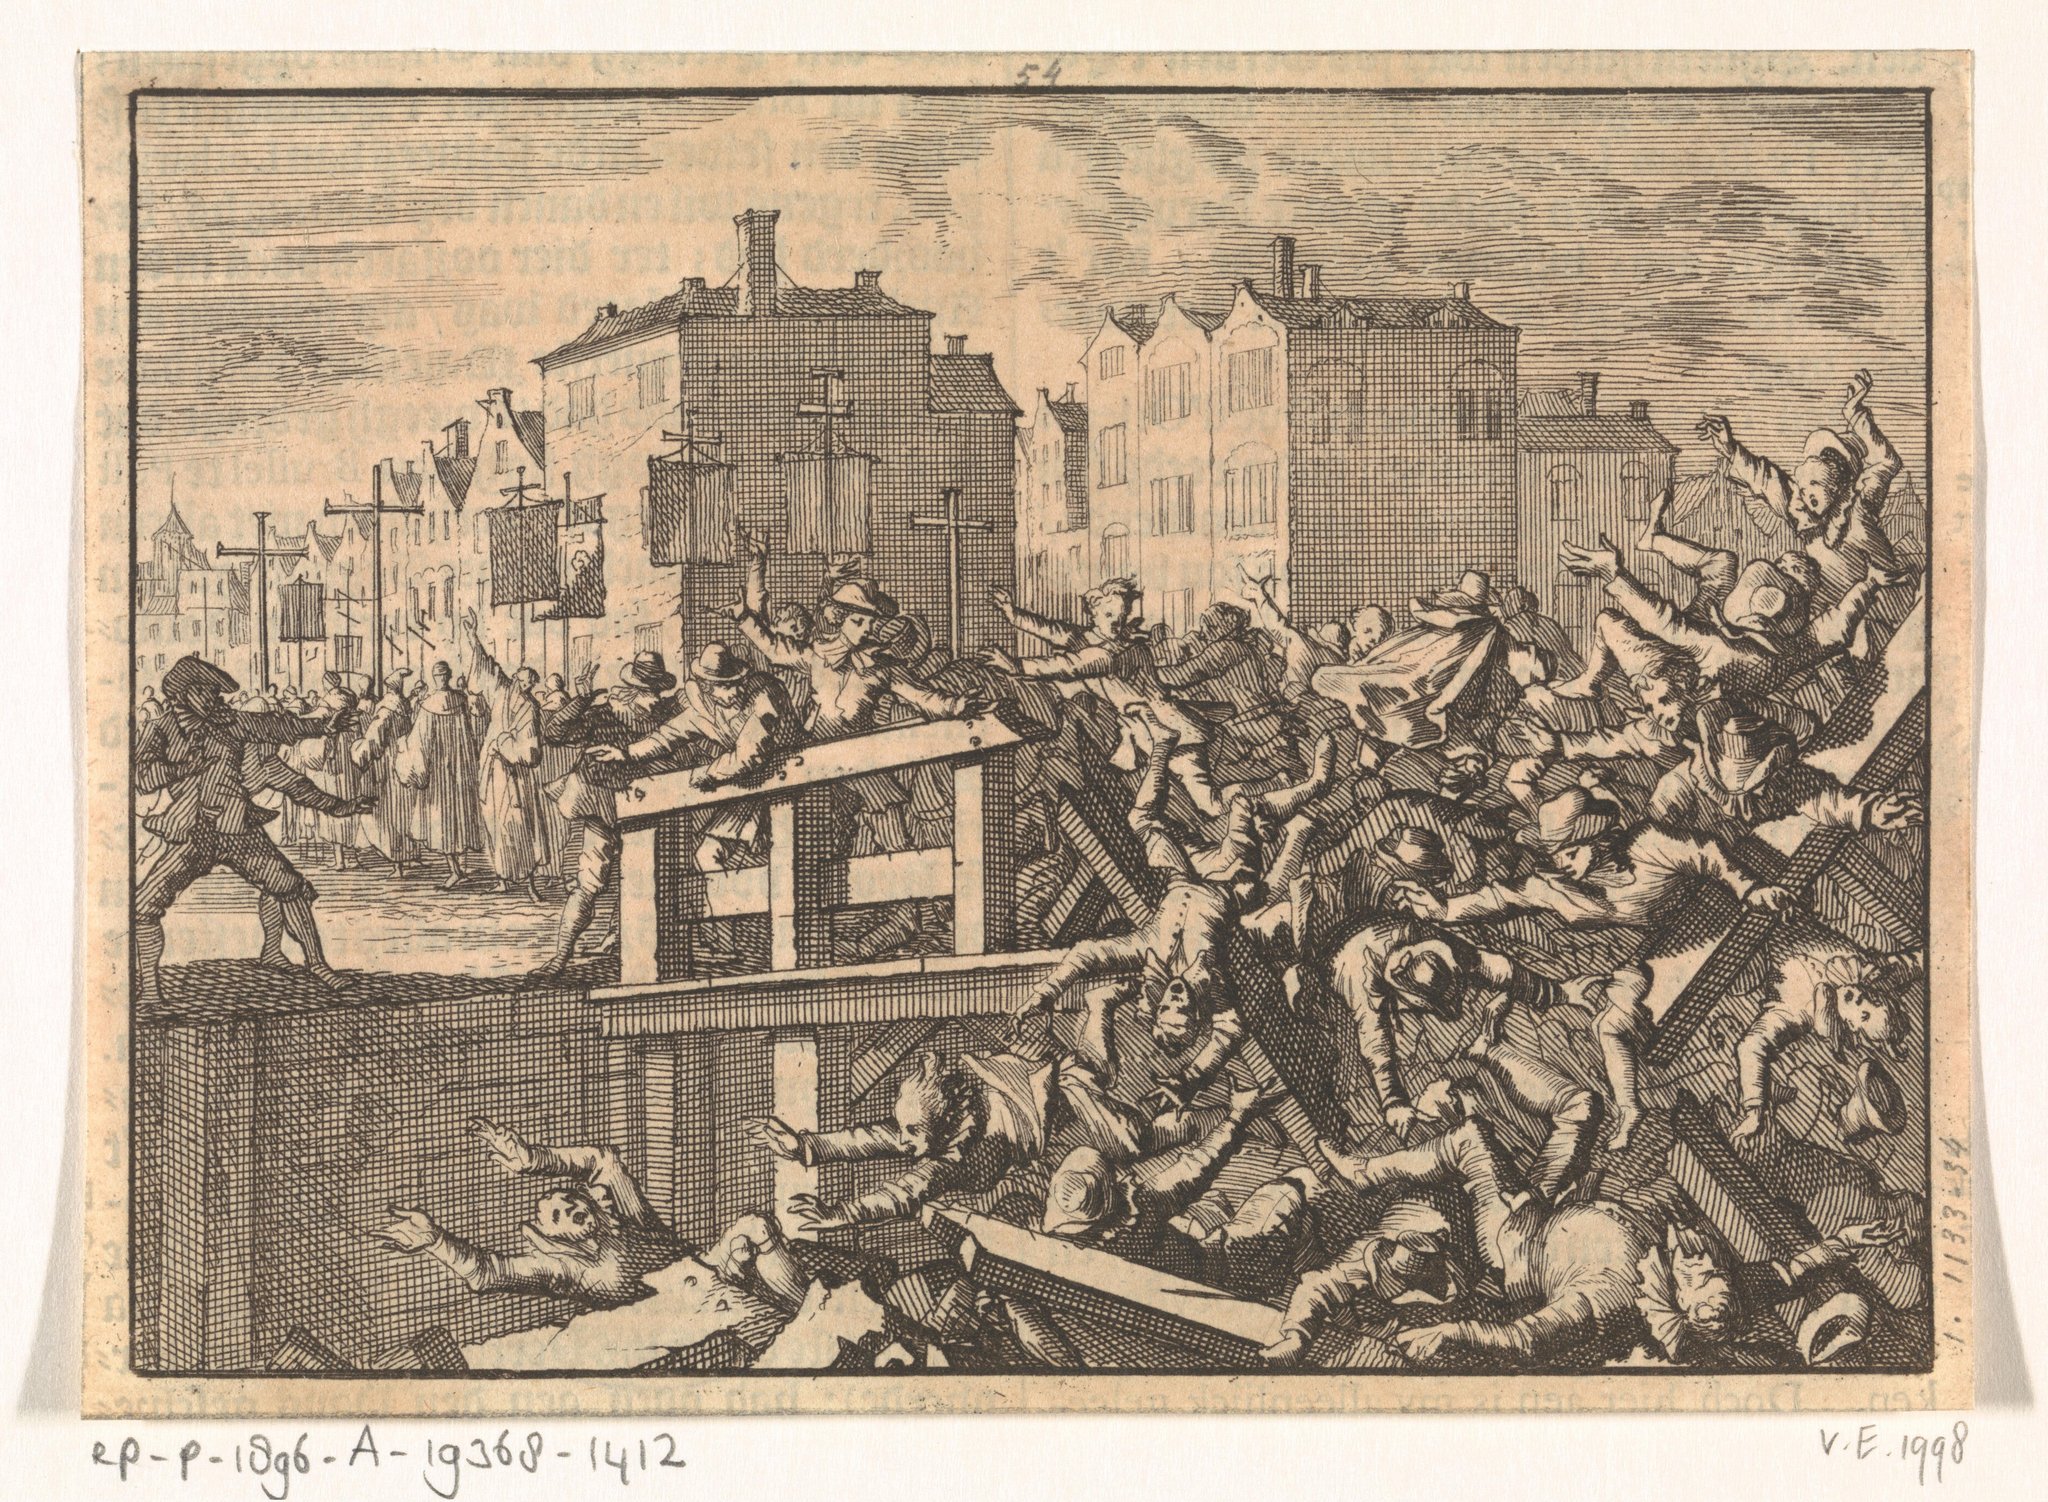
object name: book illustration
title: Brug te Parijs stort in tijdens een processie, 1633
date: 1698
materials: paper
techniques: etching, letterpress printing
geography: amsterdam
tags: collapsing building (+ variant), procession ~ christian religion, bridge, paris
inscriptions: collector's mark: Lugt 2228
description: Illustratie uit: Gottfried, Johann Ludwig. Historische kronyck; vervattende een (...) beschrijvingh der aldergedenckwaerdigste geschiedenissen des weerelds, van den aenvangh der scheppingh tot (...) 1576 (2 delen). Leiden: Pieter van der Aa, 1698, dl. I, p. 1133.